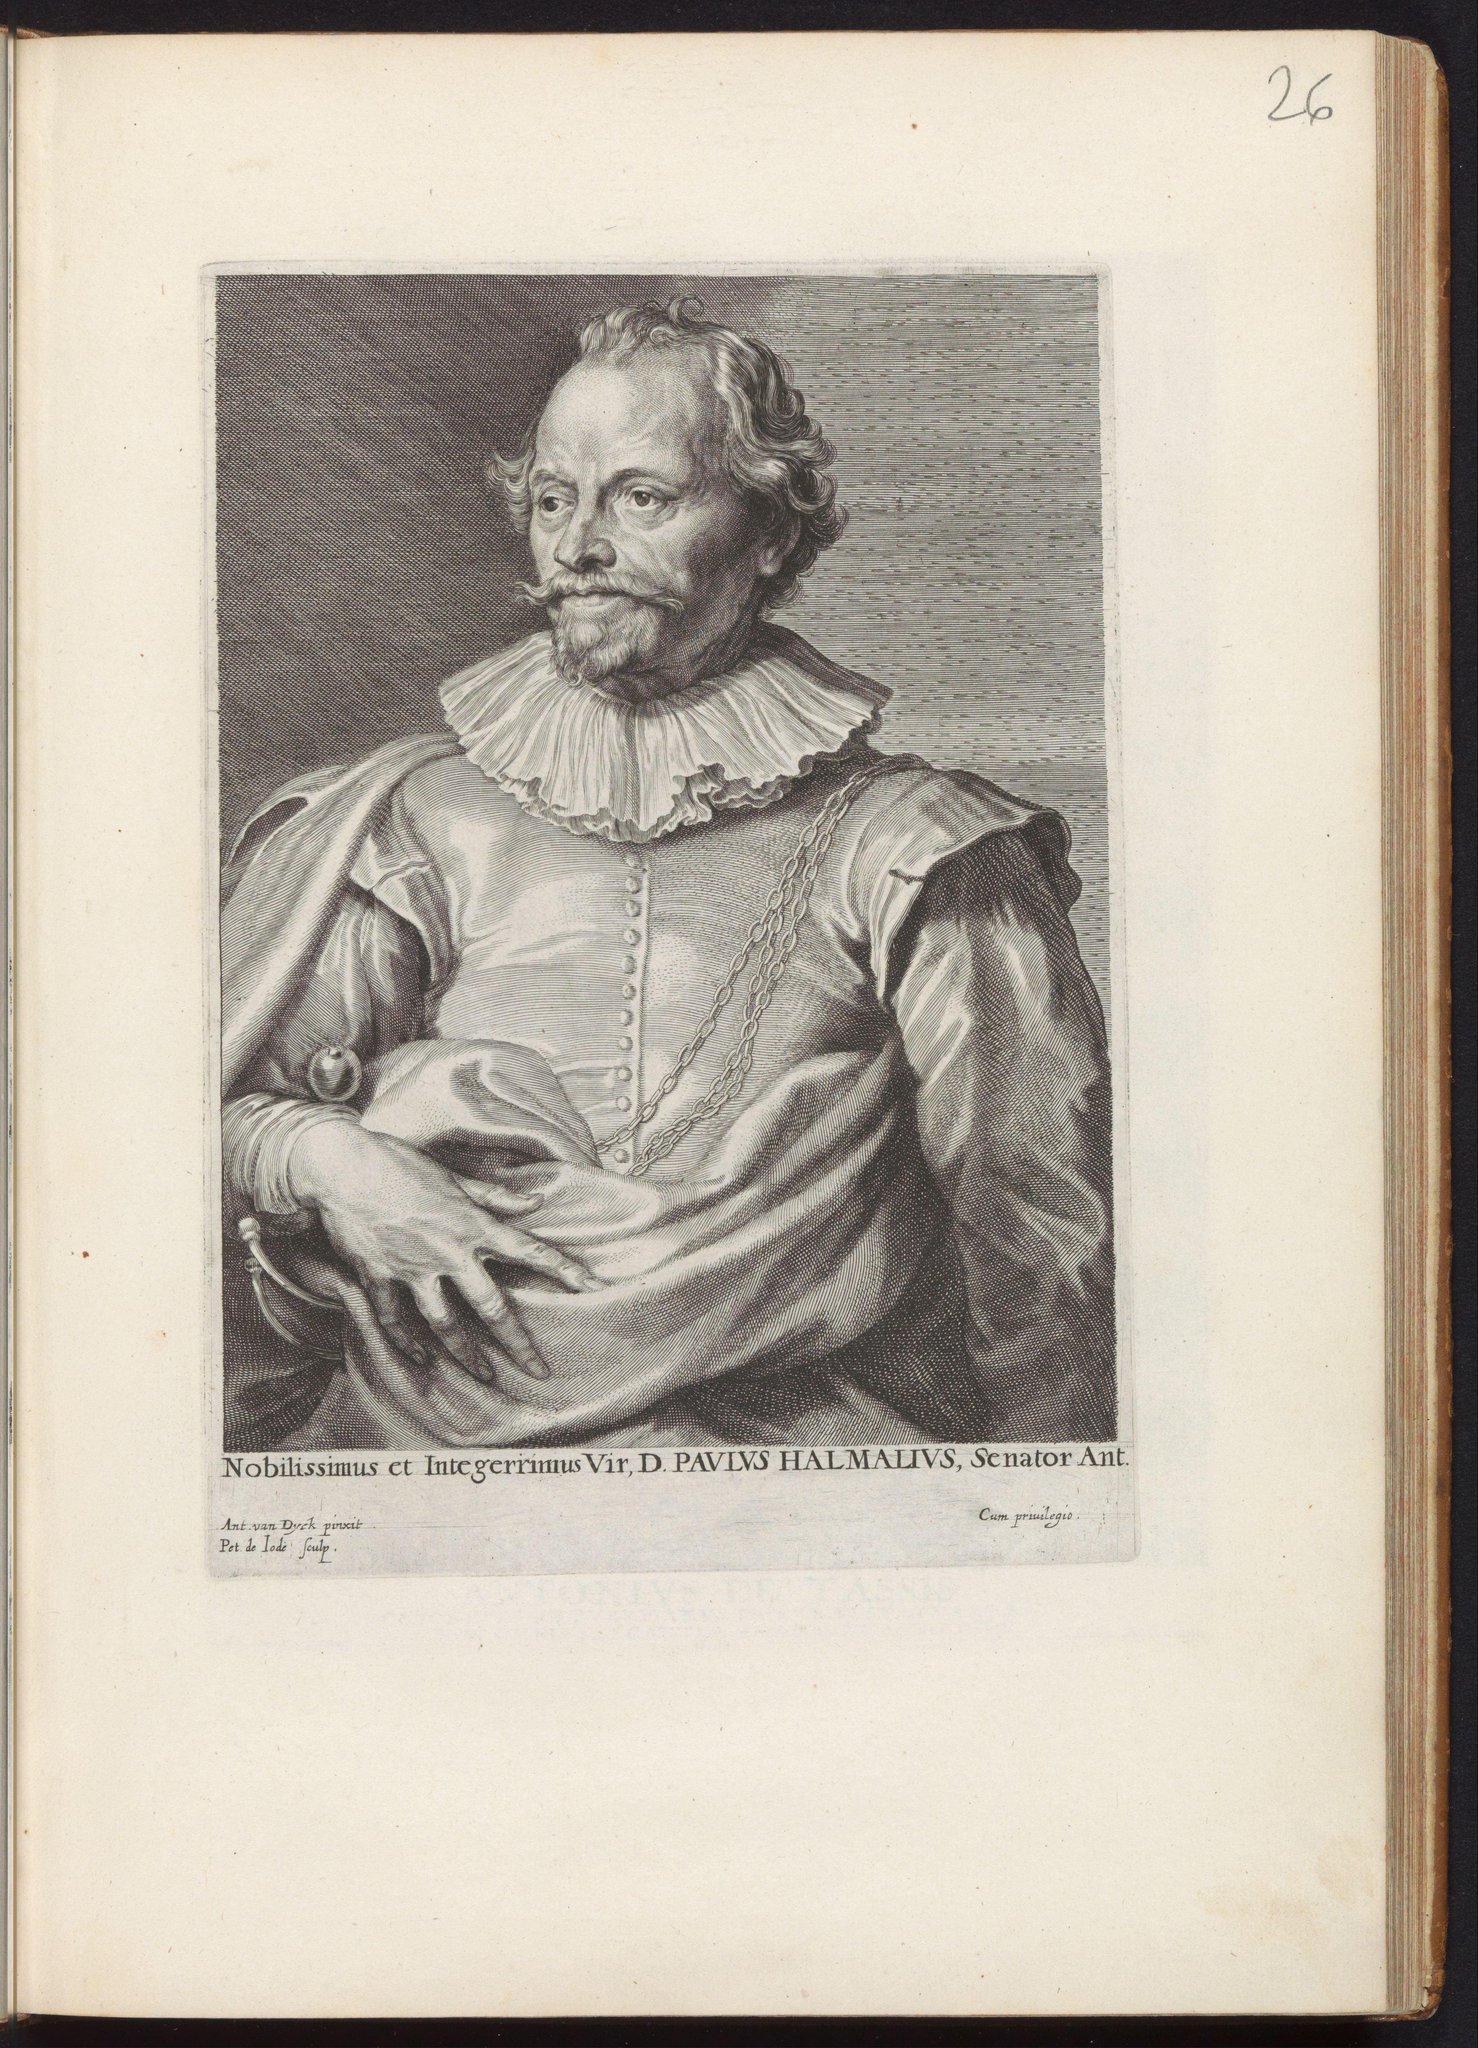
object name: print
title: Portret van Paul van Halmale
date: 1630-1641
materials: paper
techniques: engraving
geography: antwerp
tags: paul van halmale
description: Portret van Paul van Halmale, senator te Antwerpen. Deze prent maakt deel uit van een album.